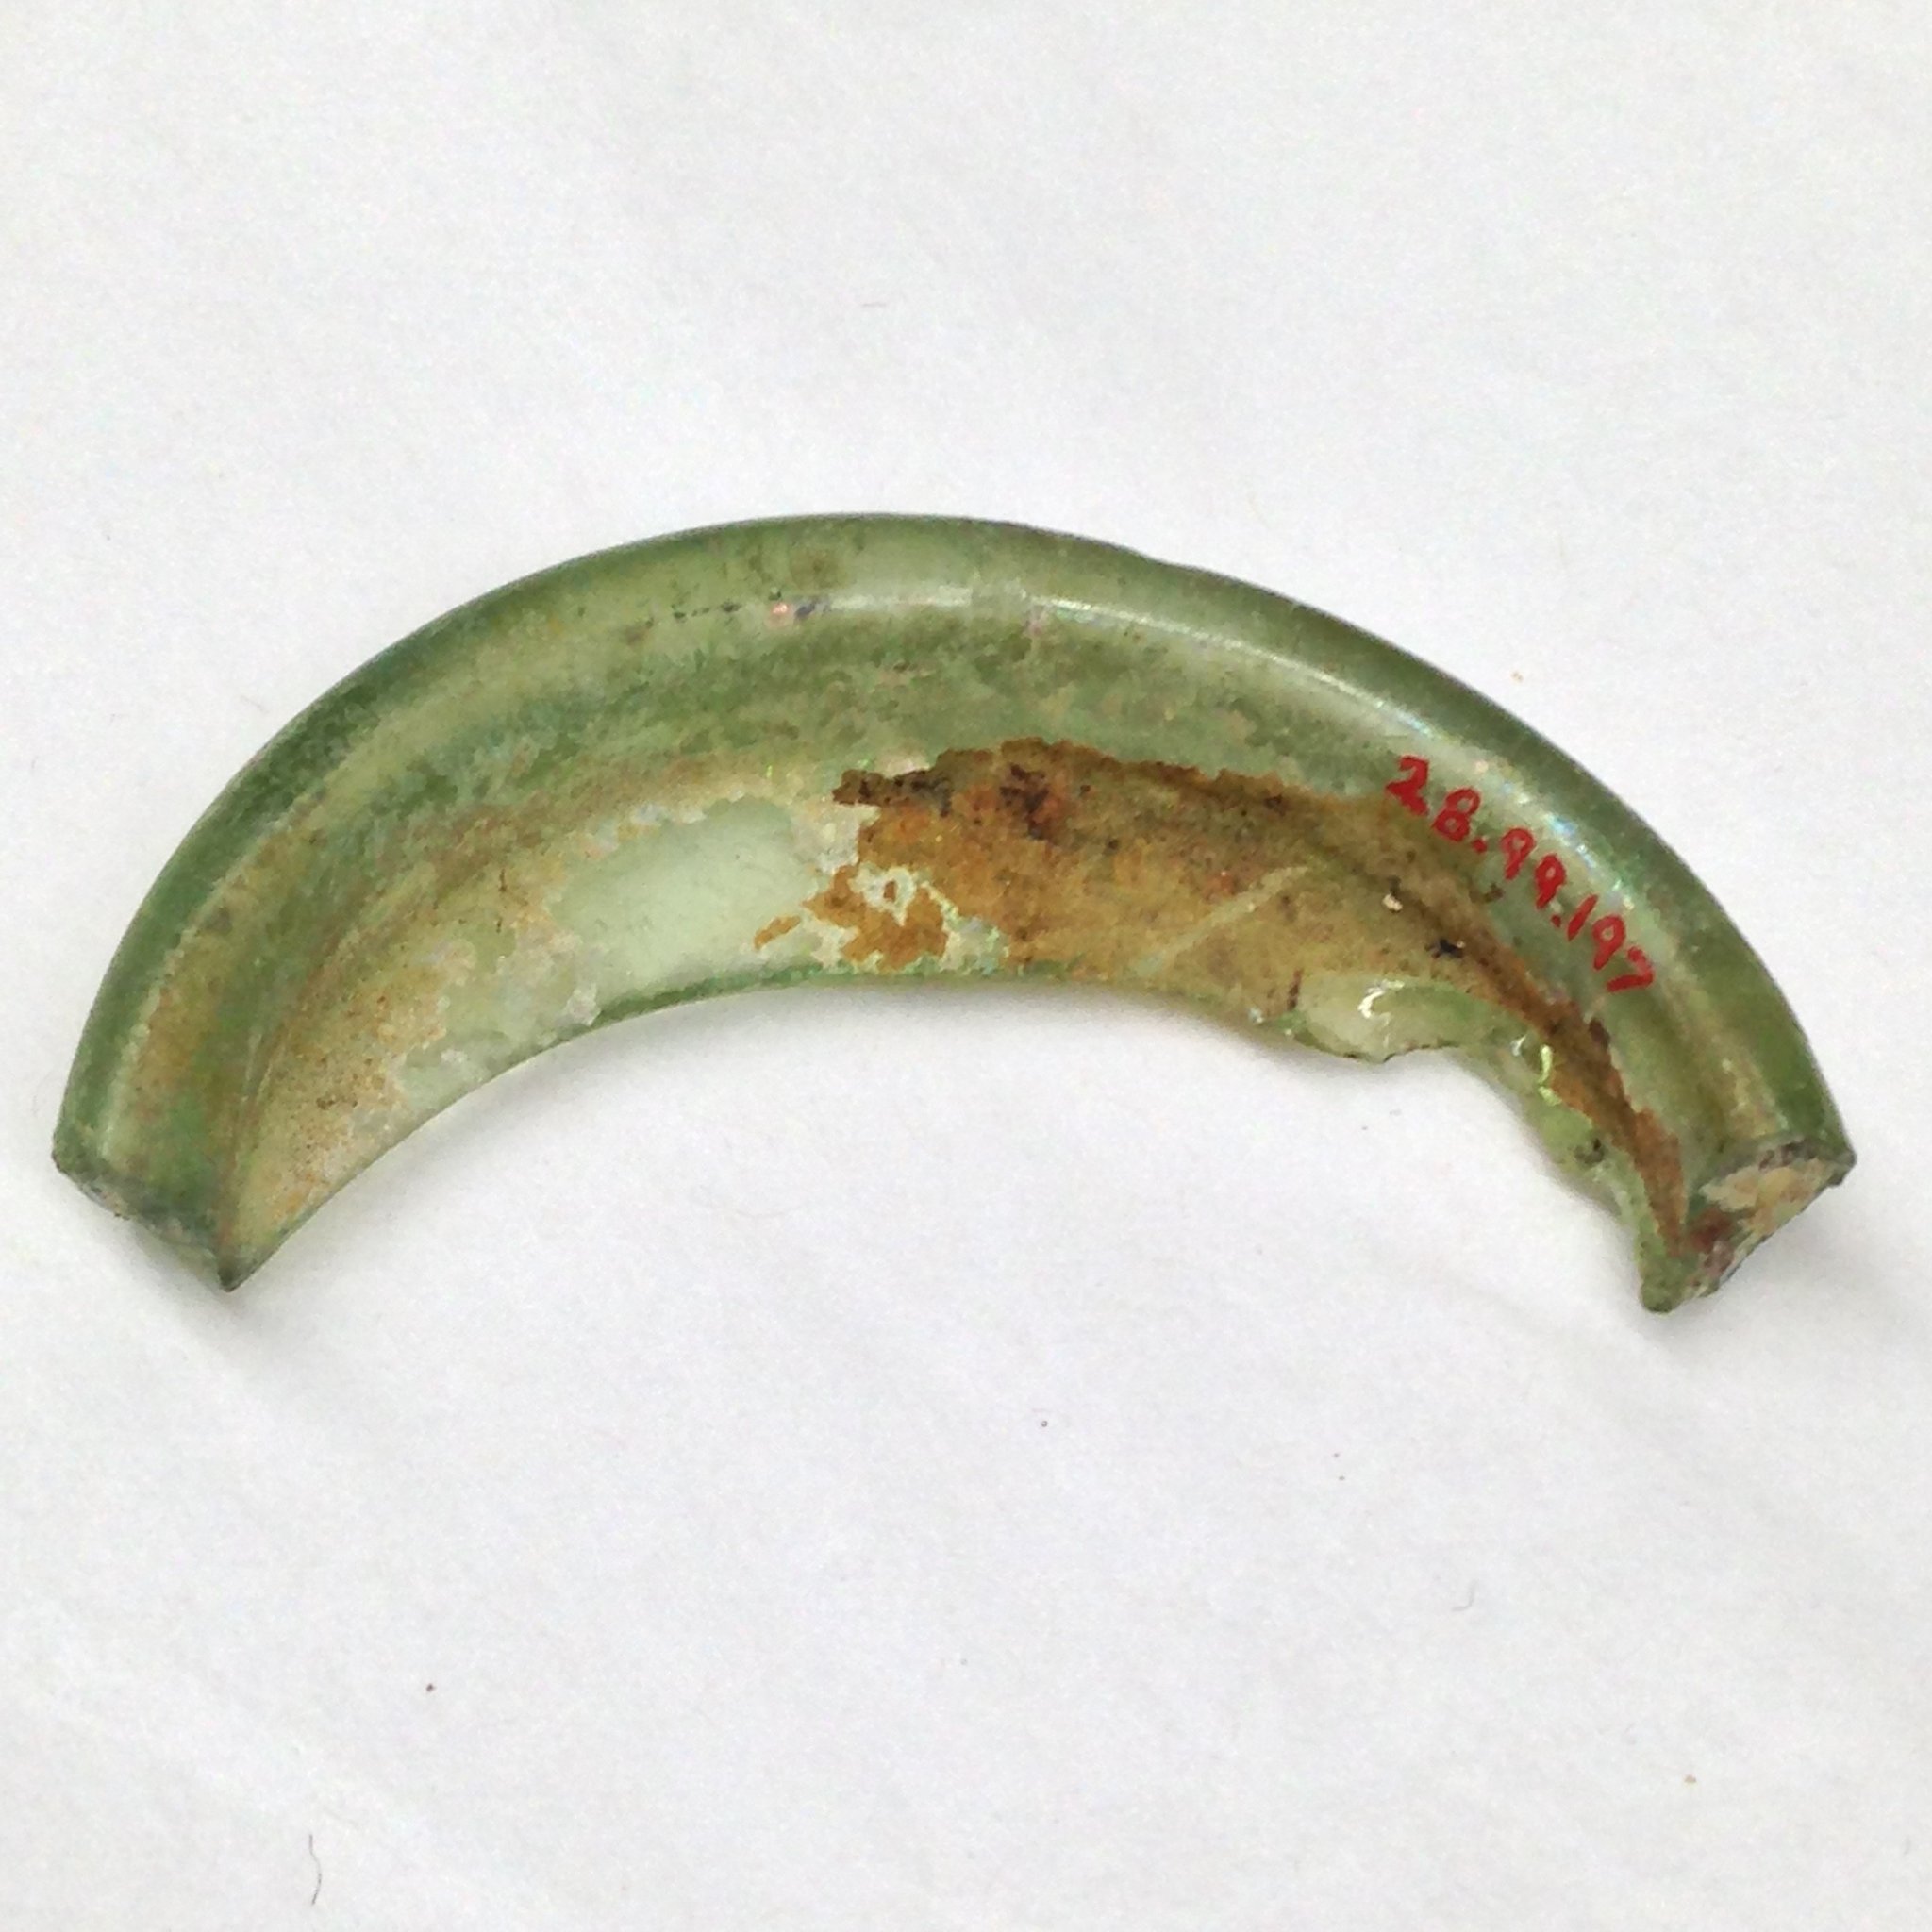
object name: fragment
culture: european or middle eastern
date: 1150-1250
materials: ceramic, glass